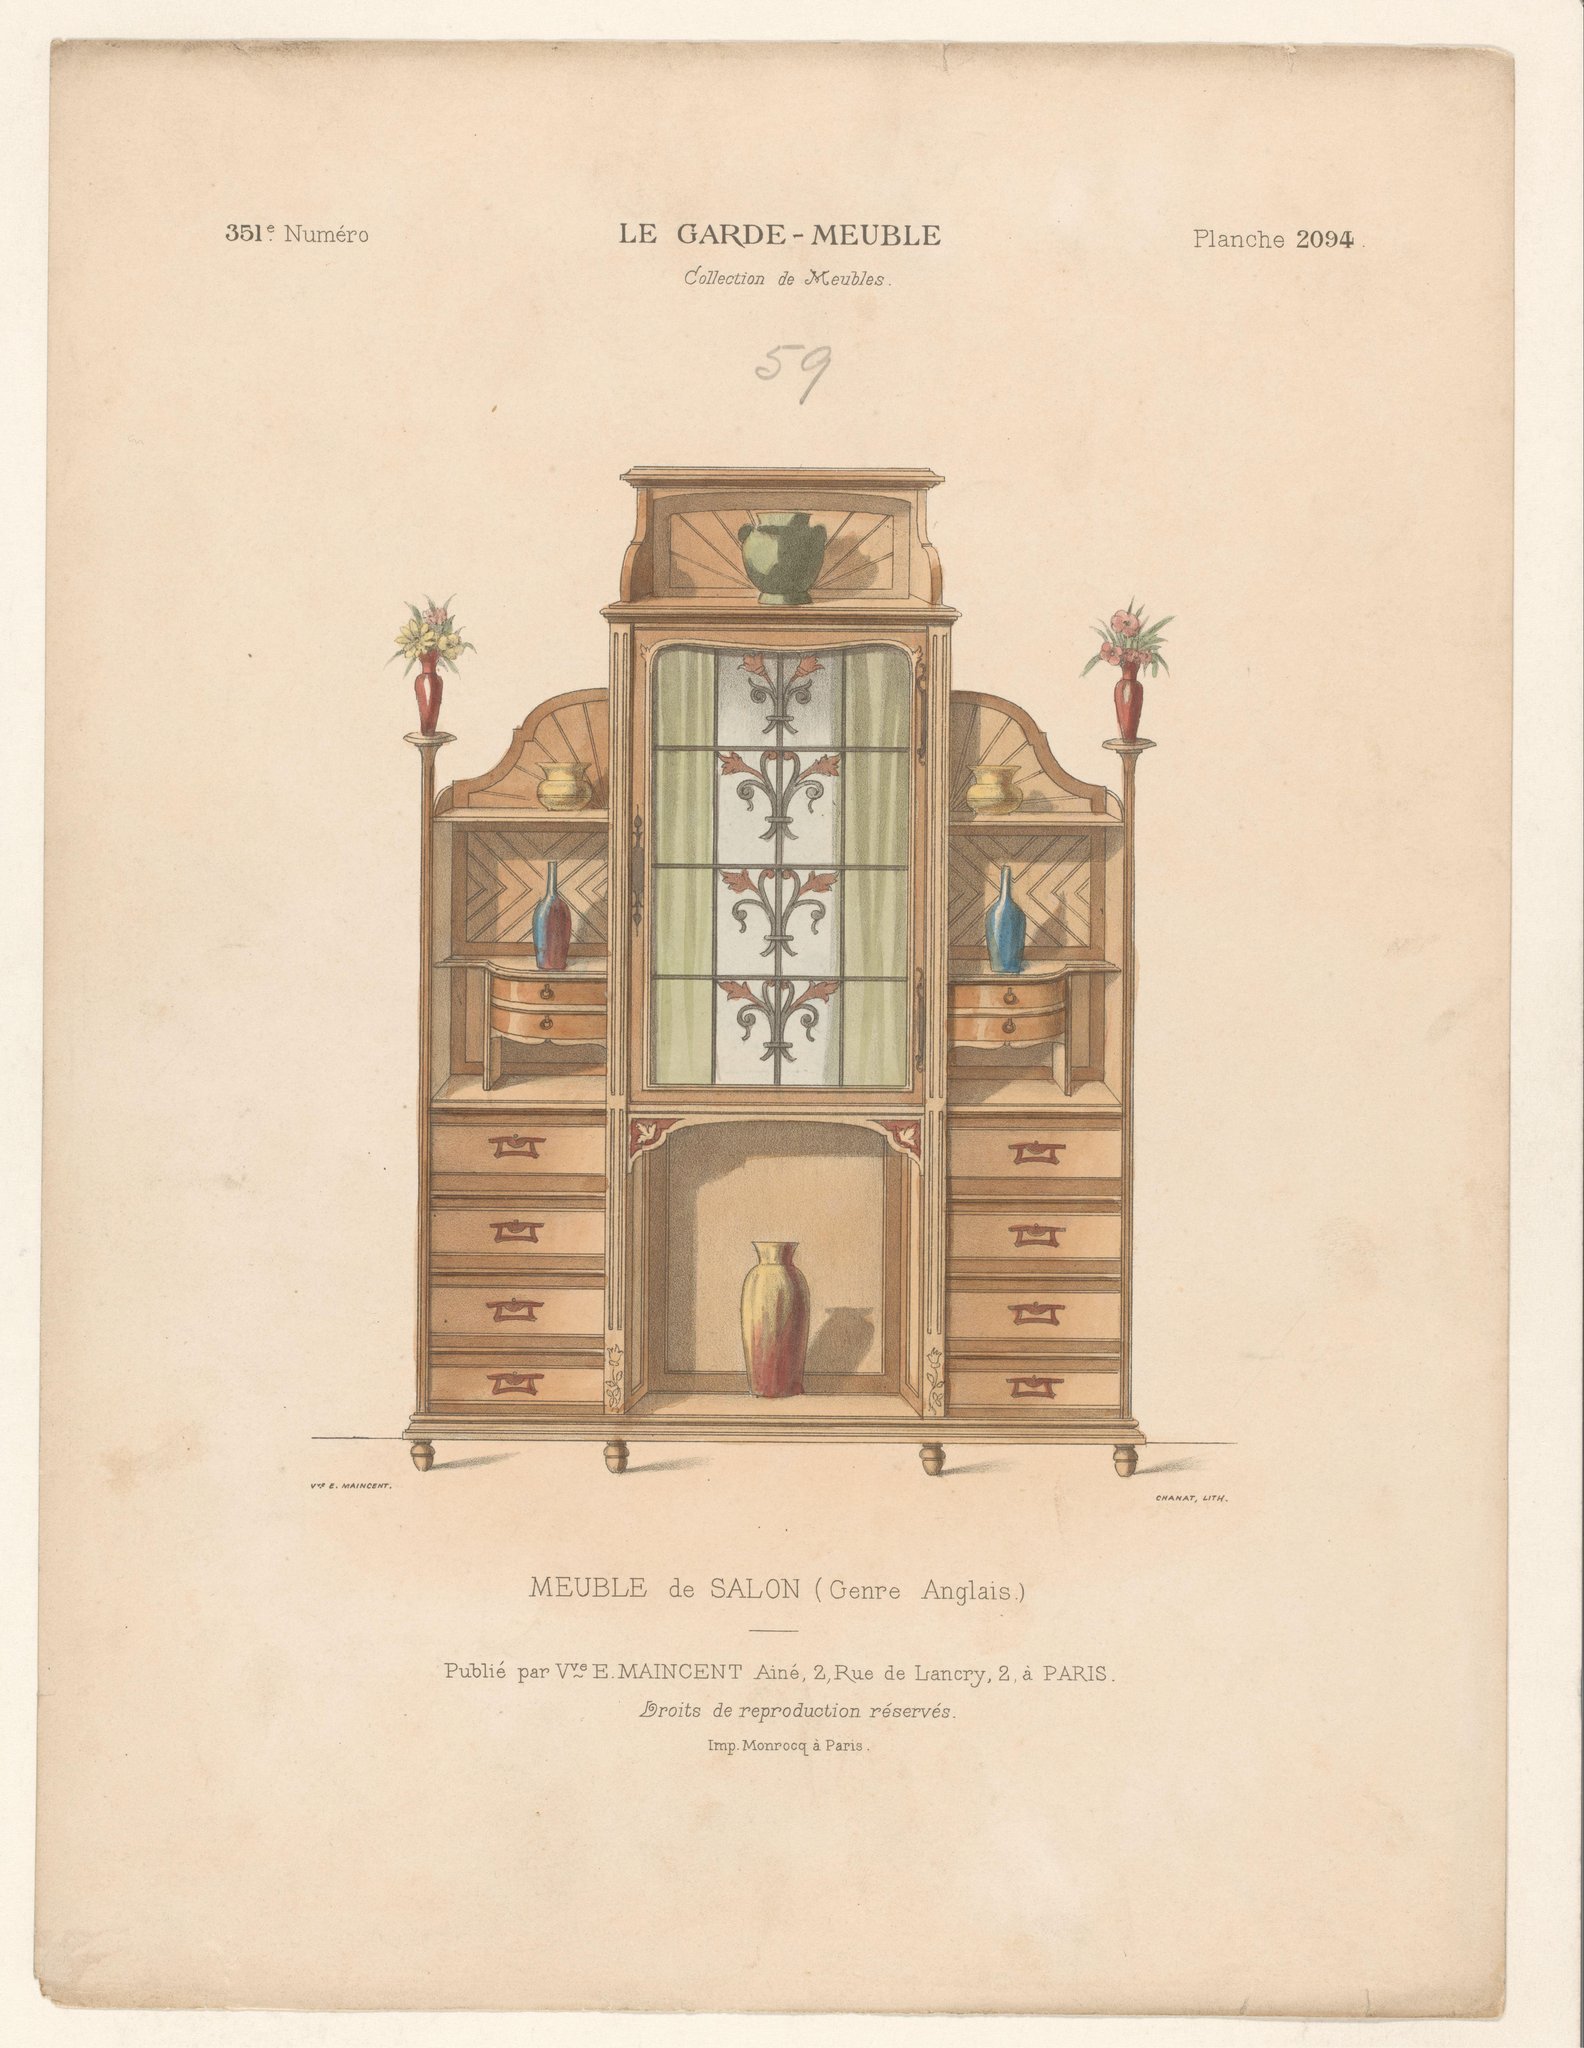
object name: print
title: Kast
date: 1895-1935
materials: paper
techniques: hand coloring, lithograph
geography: paris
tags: furniture for storage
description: Ieder Livraison in de serie Le Garde-Meuble bevat negen platen: drie 'sièges' (zitmeubels), drie 'meubles' (diverse meubels zoals tafels en kasten) en drie 'tentures' (gordijnen en draperieën).